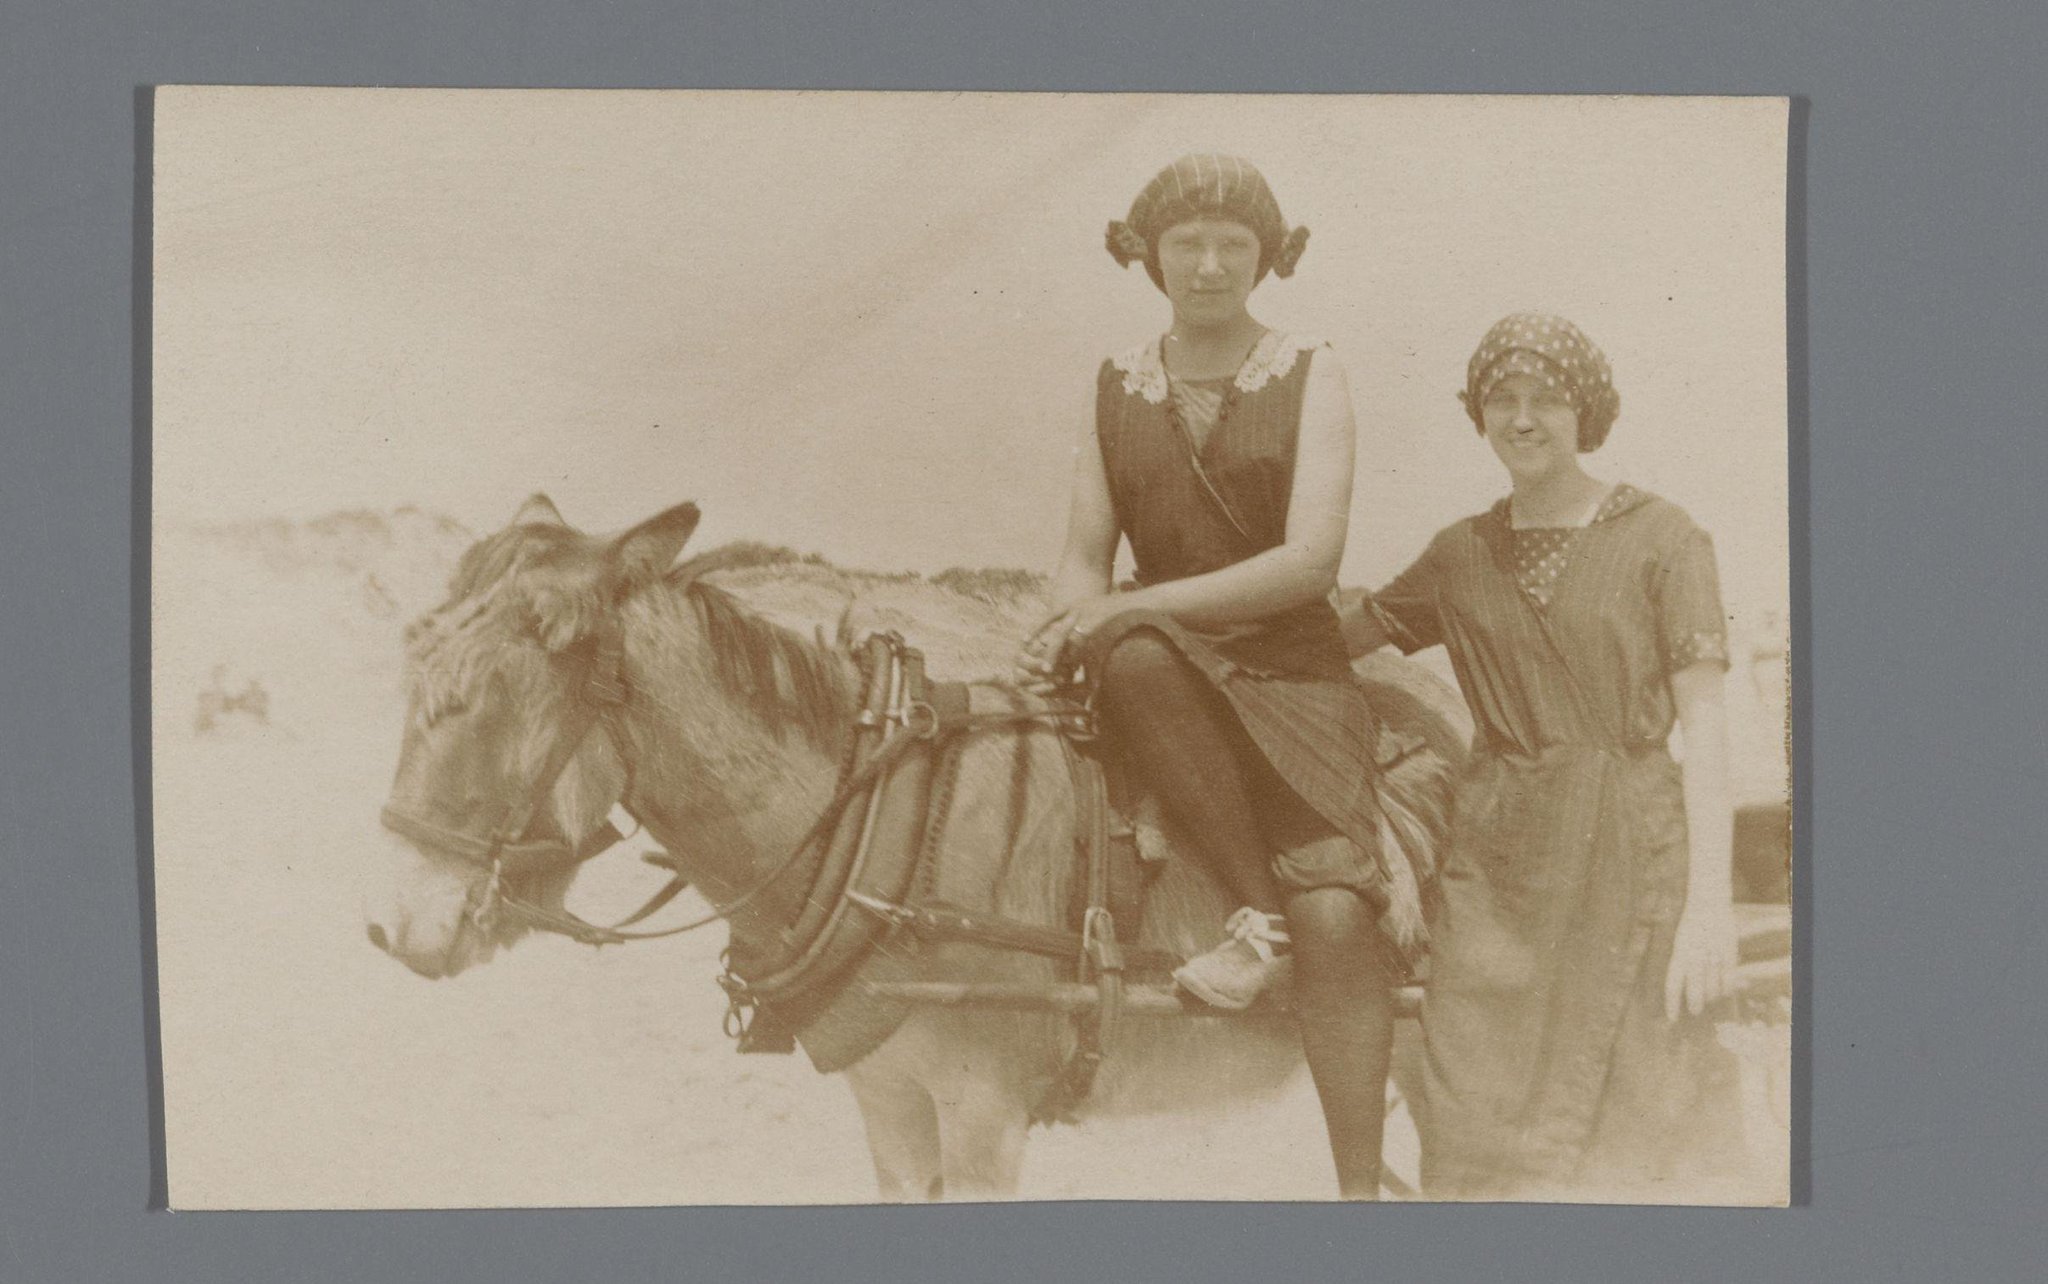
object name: photograph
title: Portret van twee onbekende vrouwen naast een ezel op een strand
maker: Anonymous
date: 1900-1915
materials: photographic support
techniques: gelatin silver print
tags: beach (as place of recreation), ass, donkey, mother and daughter(s) (family group)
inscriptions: inscription: ‘Don't you think that Grace looks just the dame as she did when you knew her. I know I don't, because I've got a lot stouter. I weigh 17 pounds more then when i got married.’